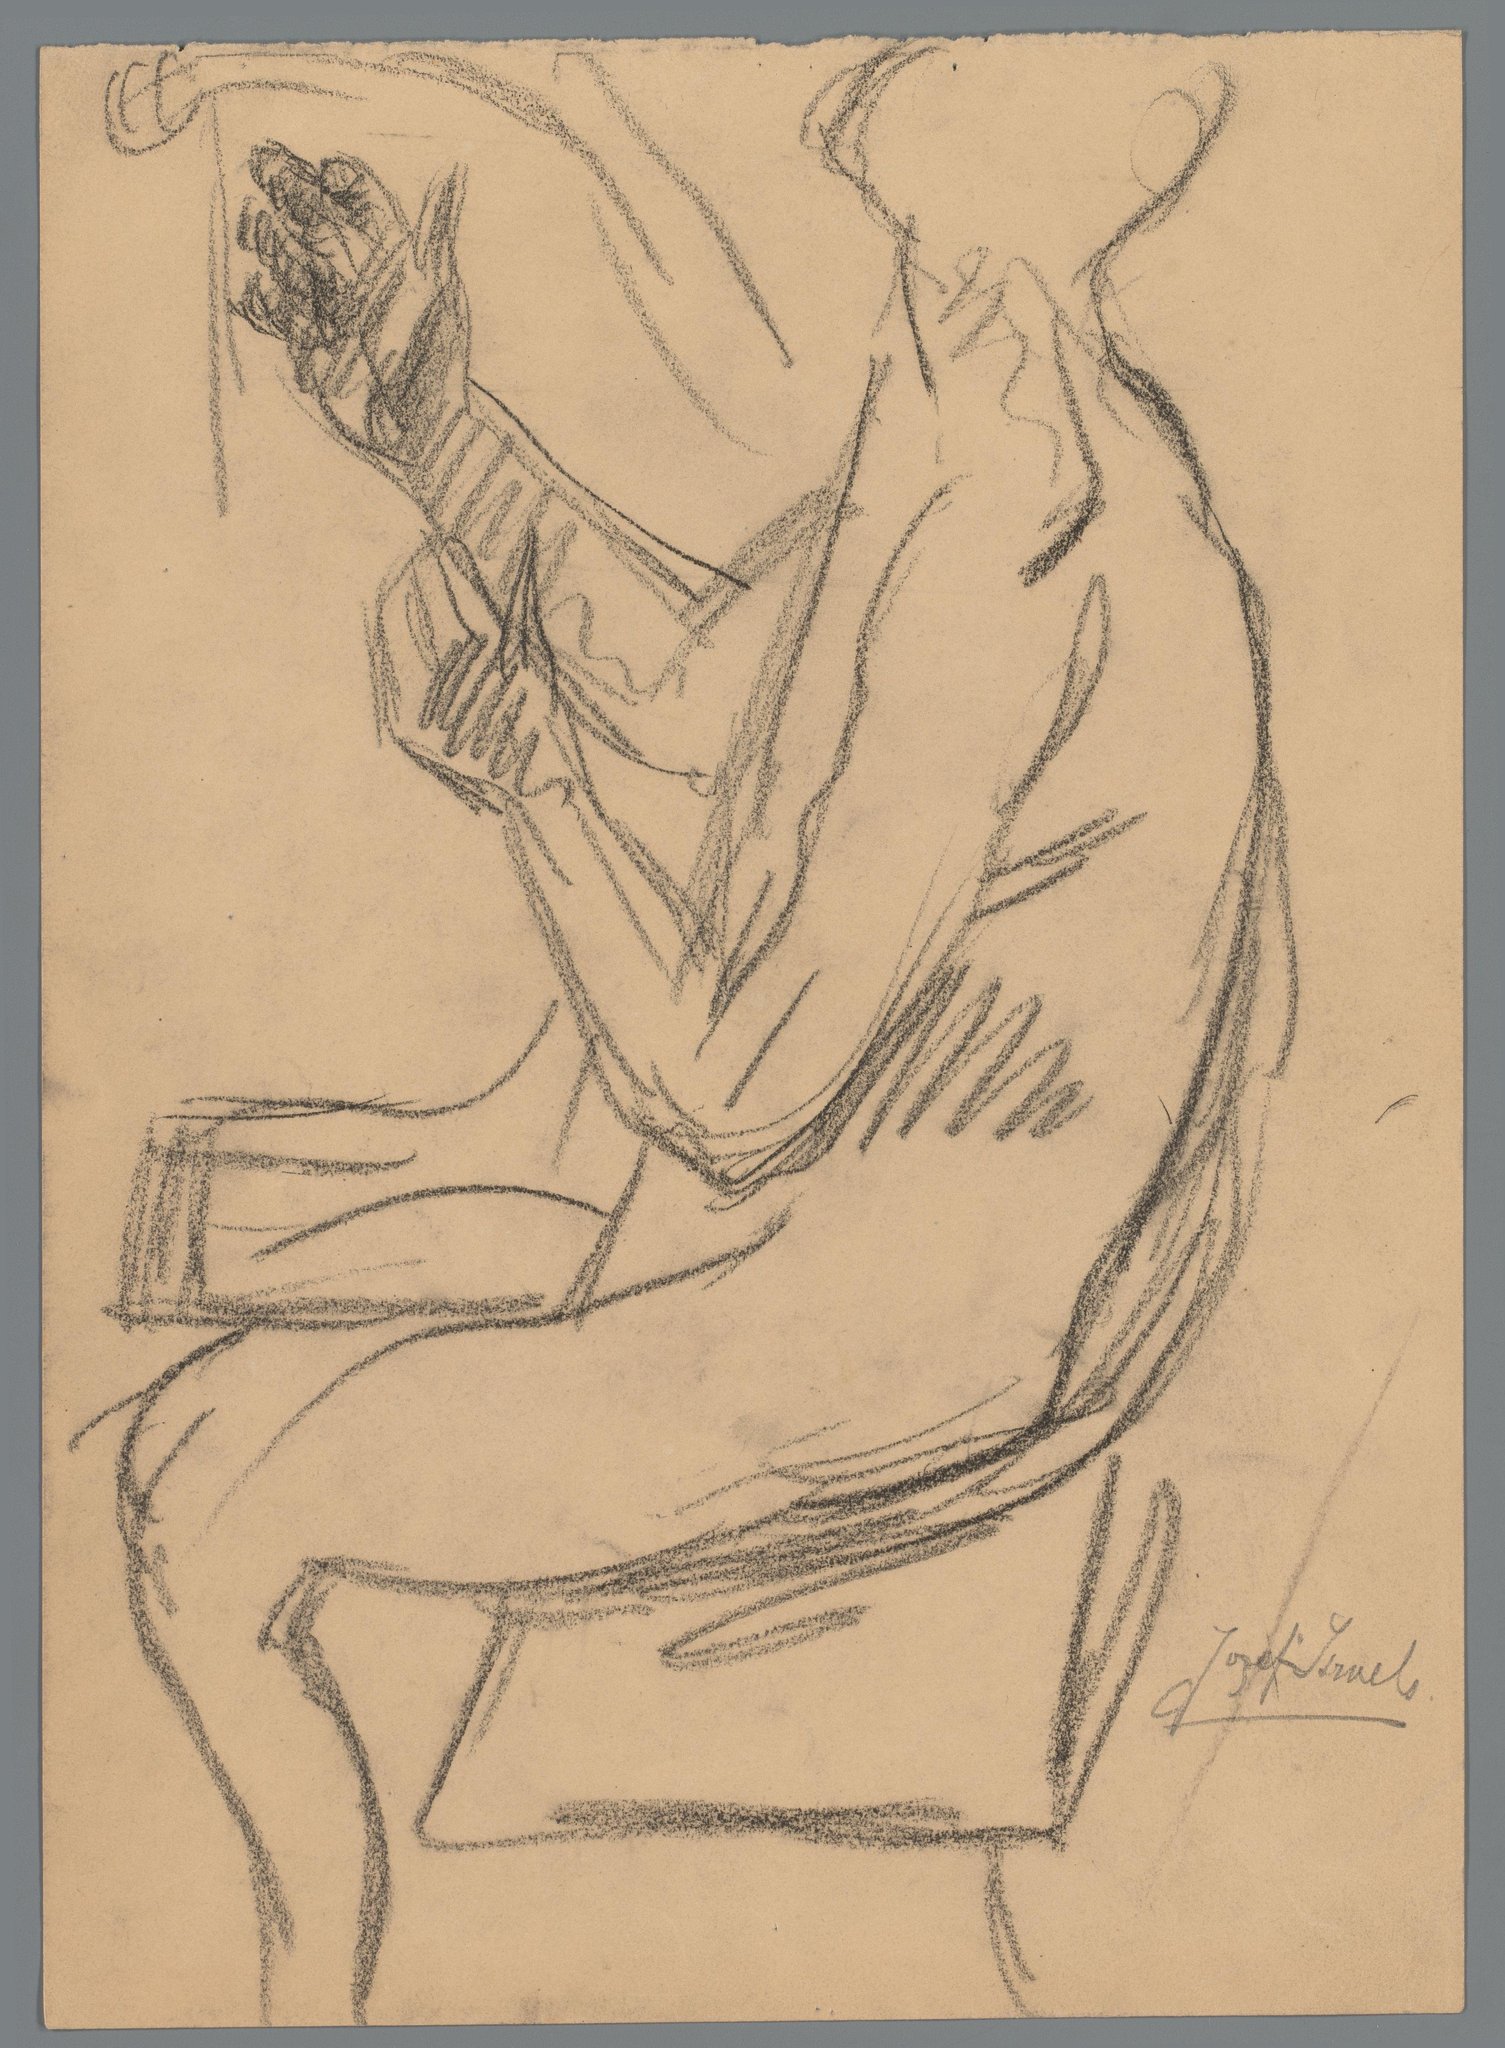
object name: drawing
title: Harpspelende David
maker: jozef israëls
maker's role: draughtsman, painter, print maker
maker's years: 1824-1911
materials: chalk, paper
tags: david as musician, usually playing the harp, harp (+ artist at work)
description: Voorstudie voor het schilderij 'David en Saul' dat zich in het Groninger Museum bevindt.